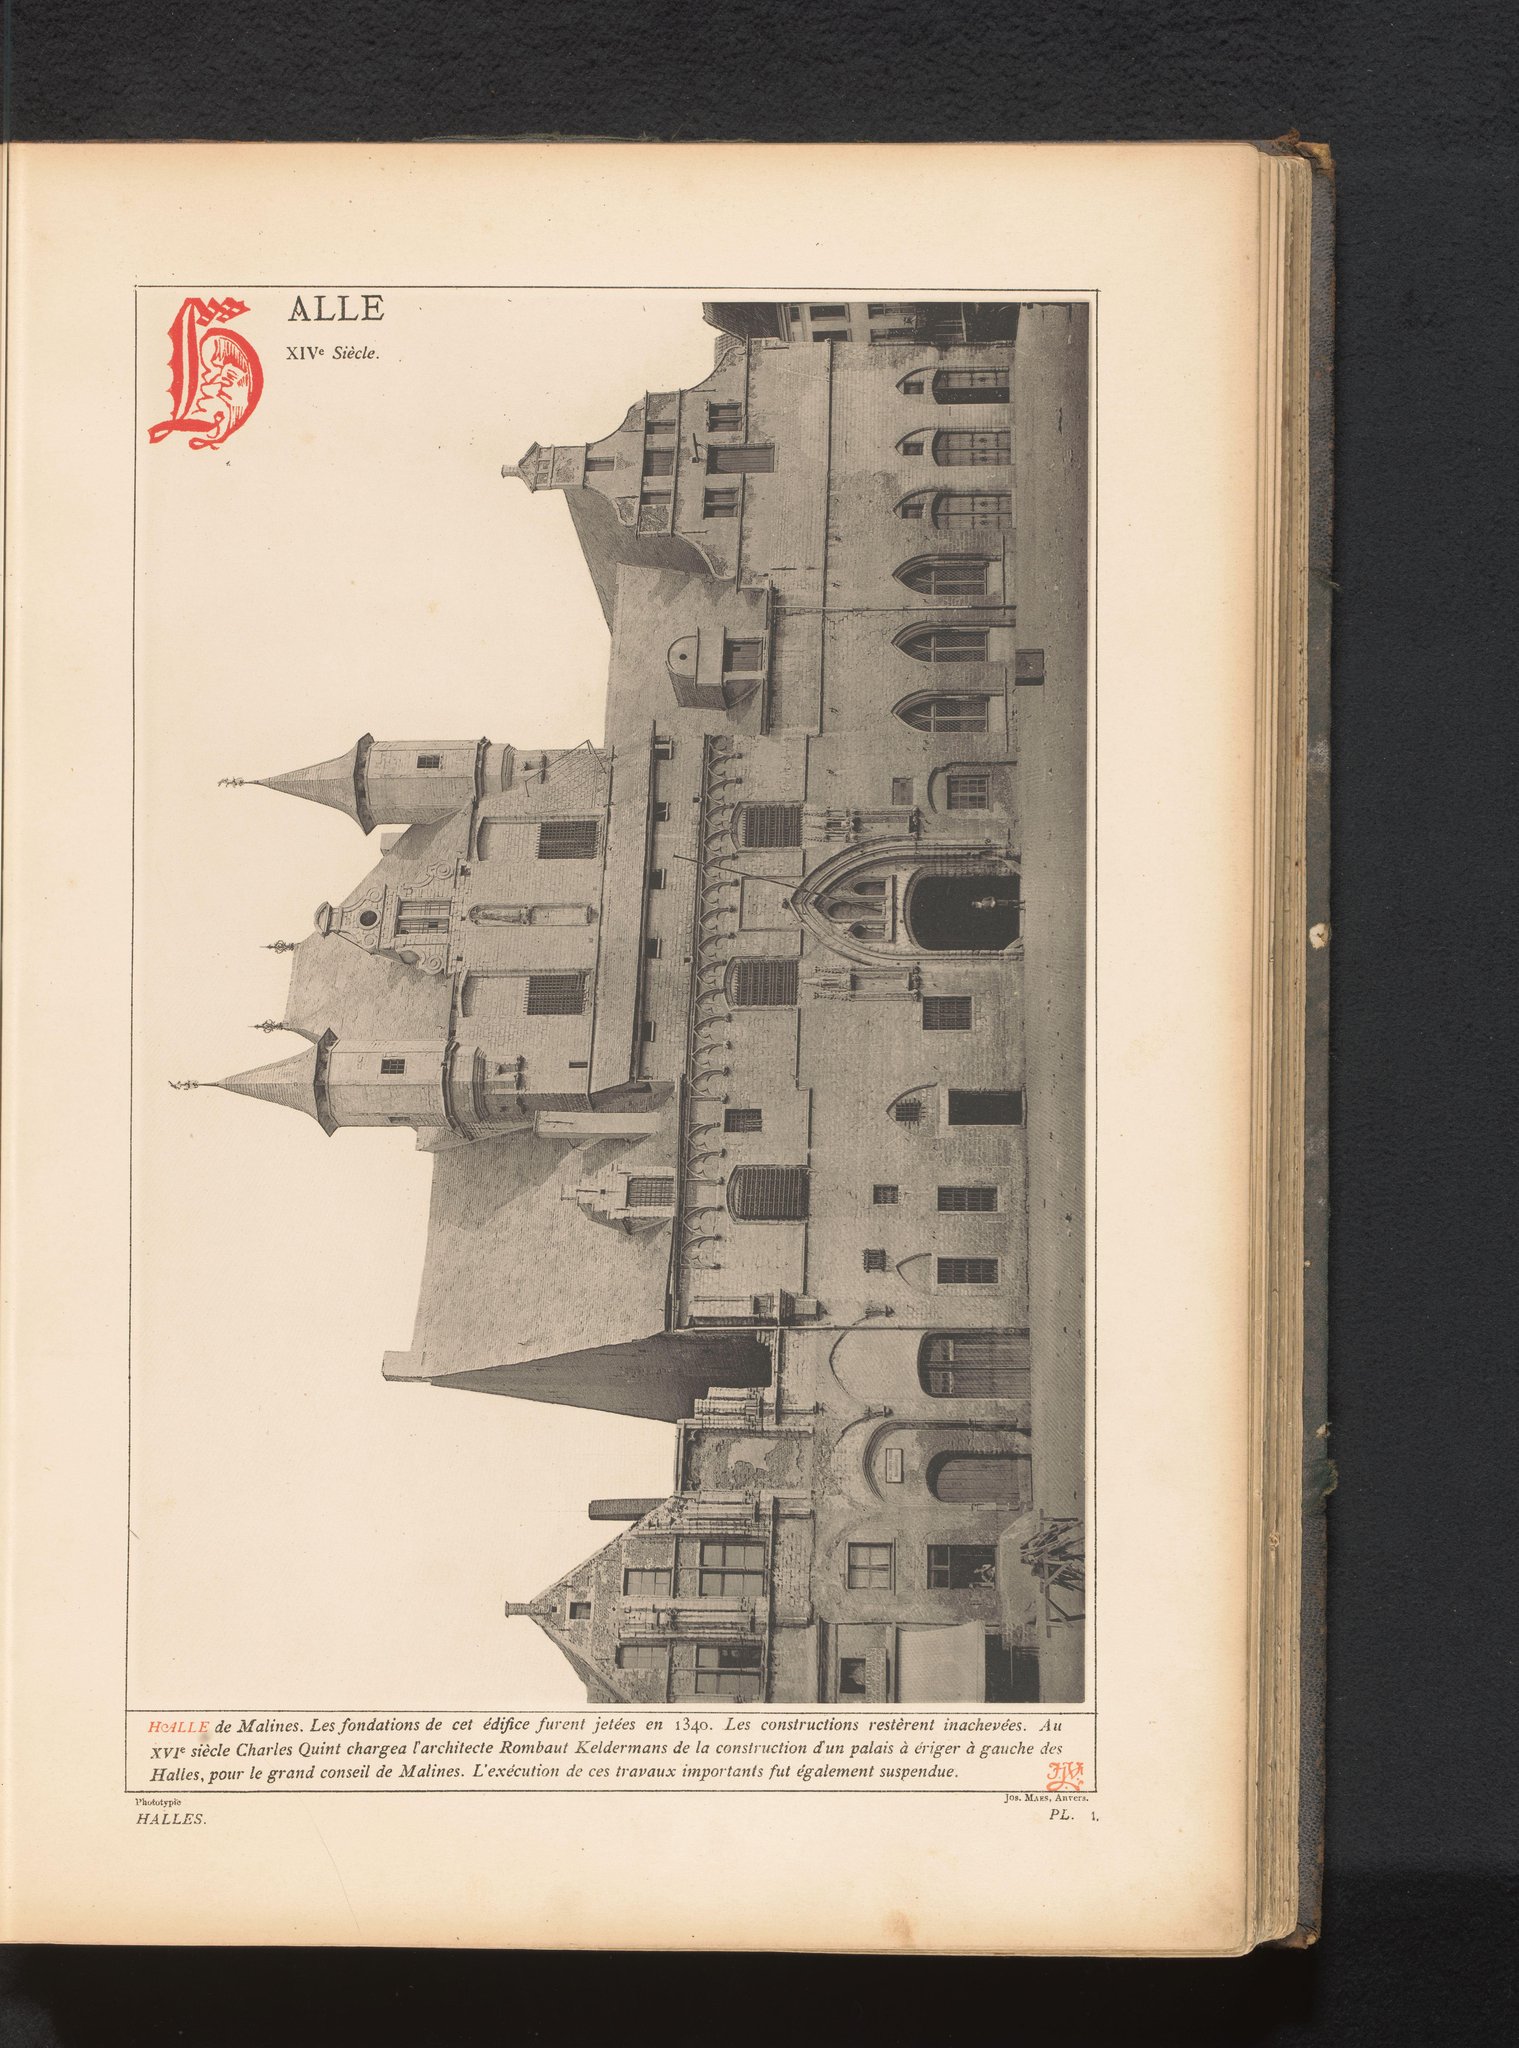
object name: photomechanical print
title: Halle, XIVe Siècle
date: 1882-1887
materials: paper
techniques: photograph, photolithography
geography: antwerp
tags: townhall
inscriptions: inscription: ‘HALLES. - PL. 1.’, inscription: ‘HALLE de Malines (...)’, monogram: ‘JJvY’